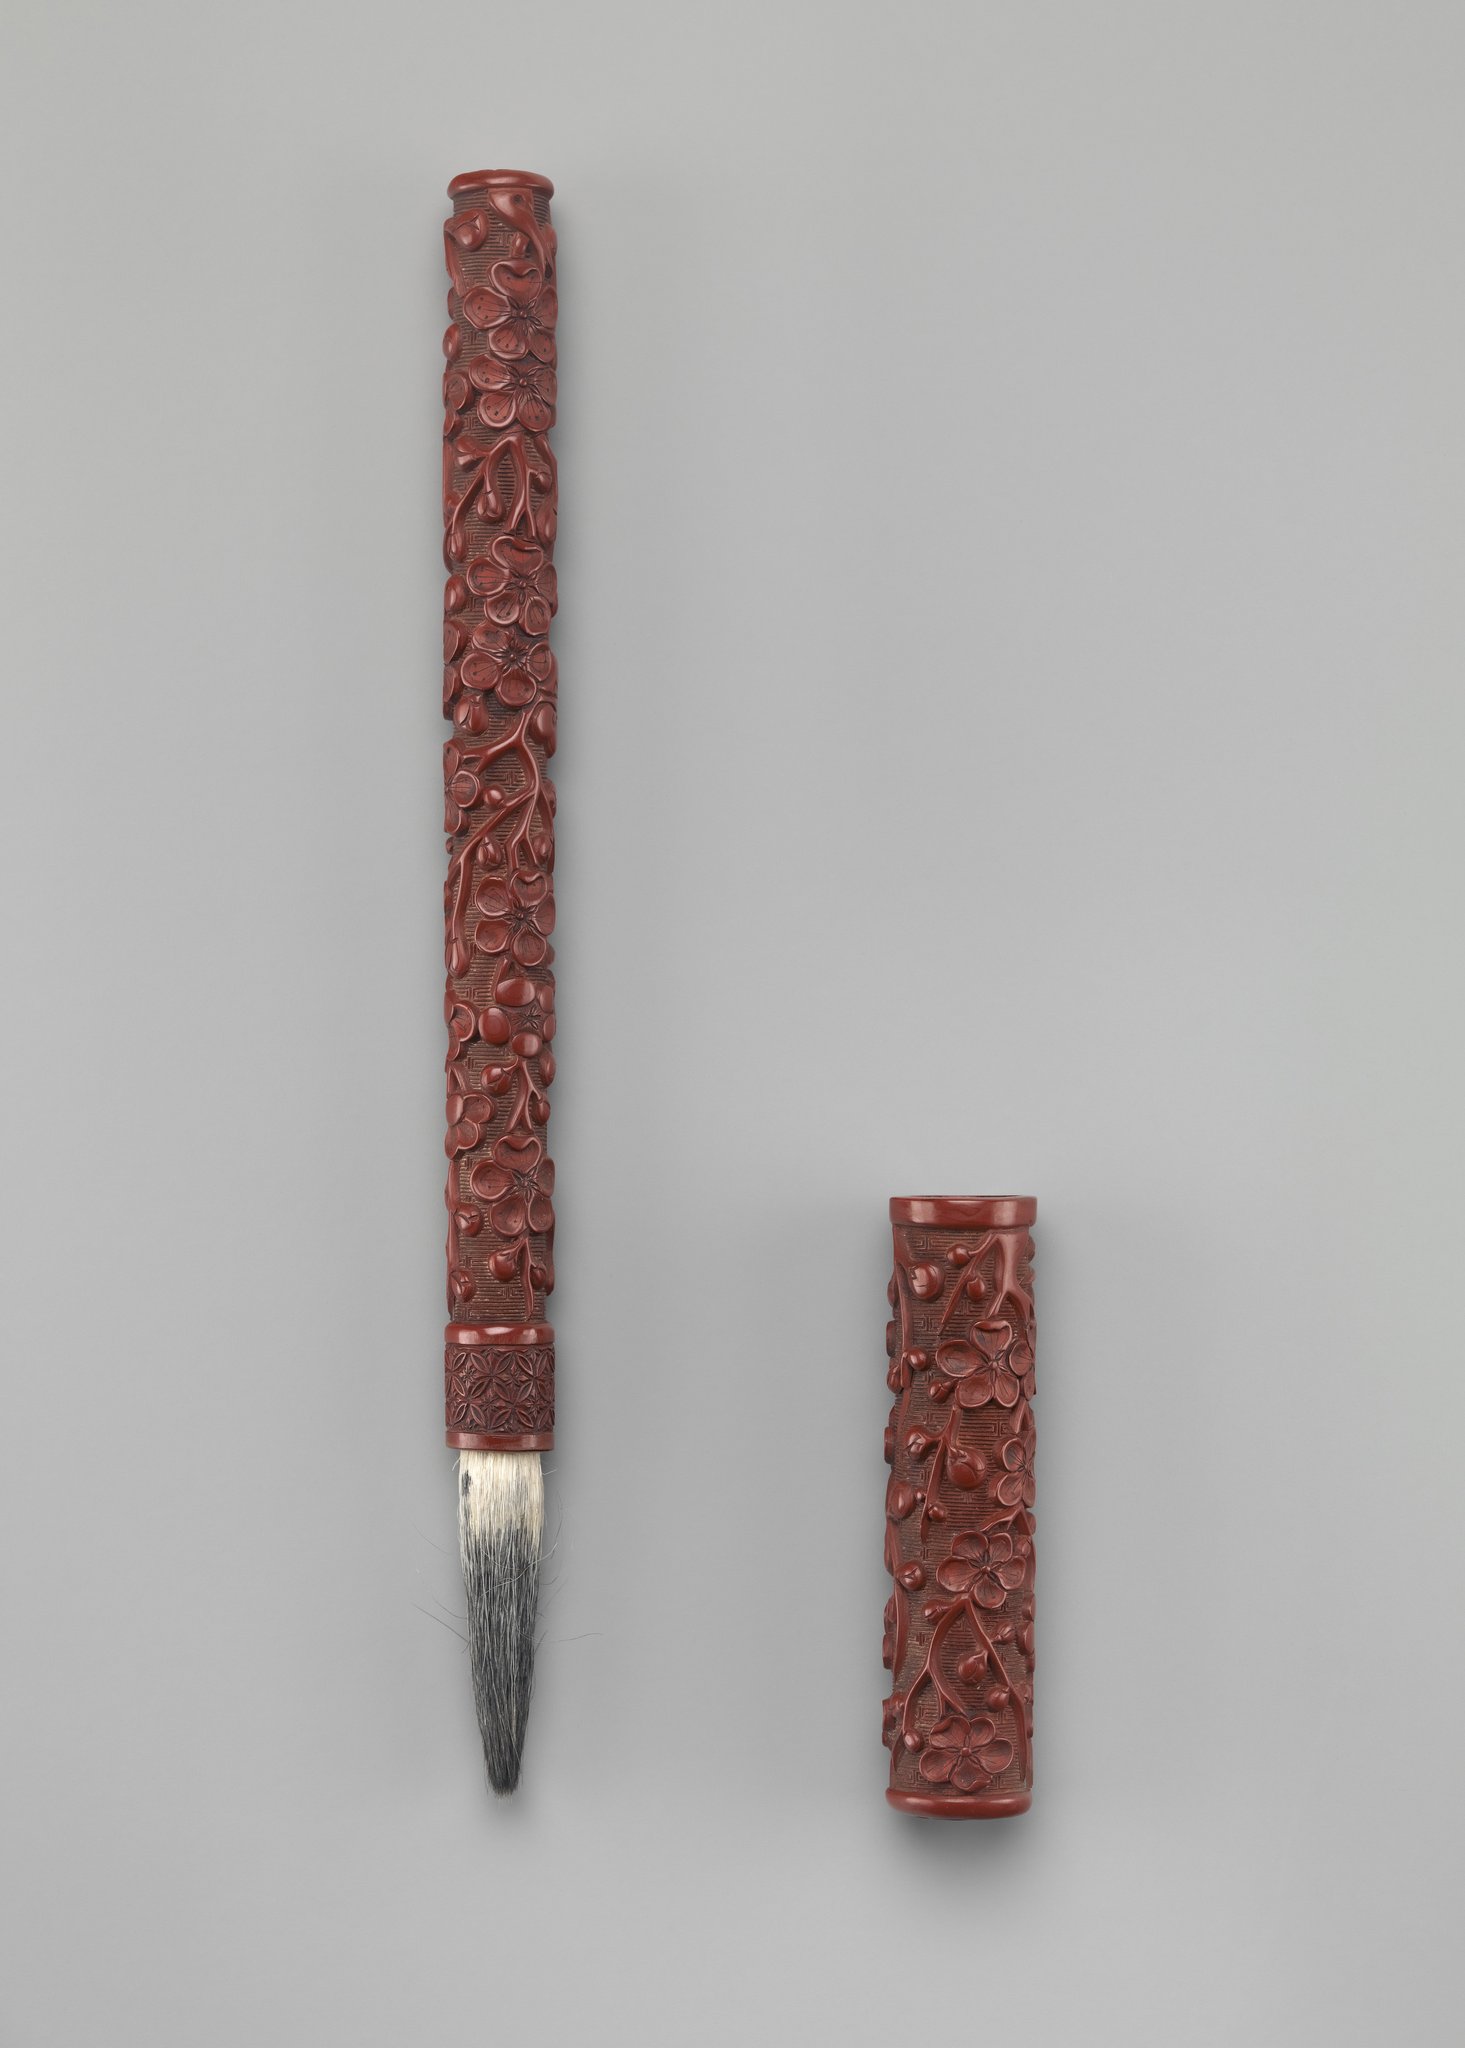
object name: brush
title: Brush with plum blossoms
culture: chinese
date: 1551-1600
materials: lacquer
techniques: carving